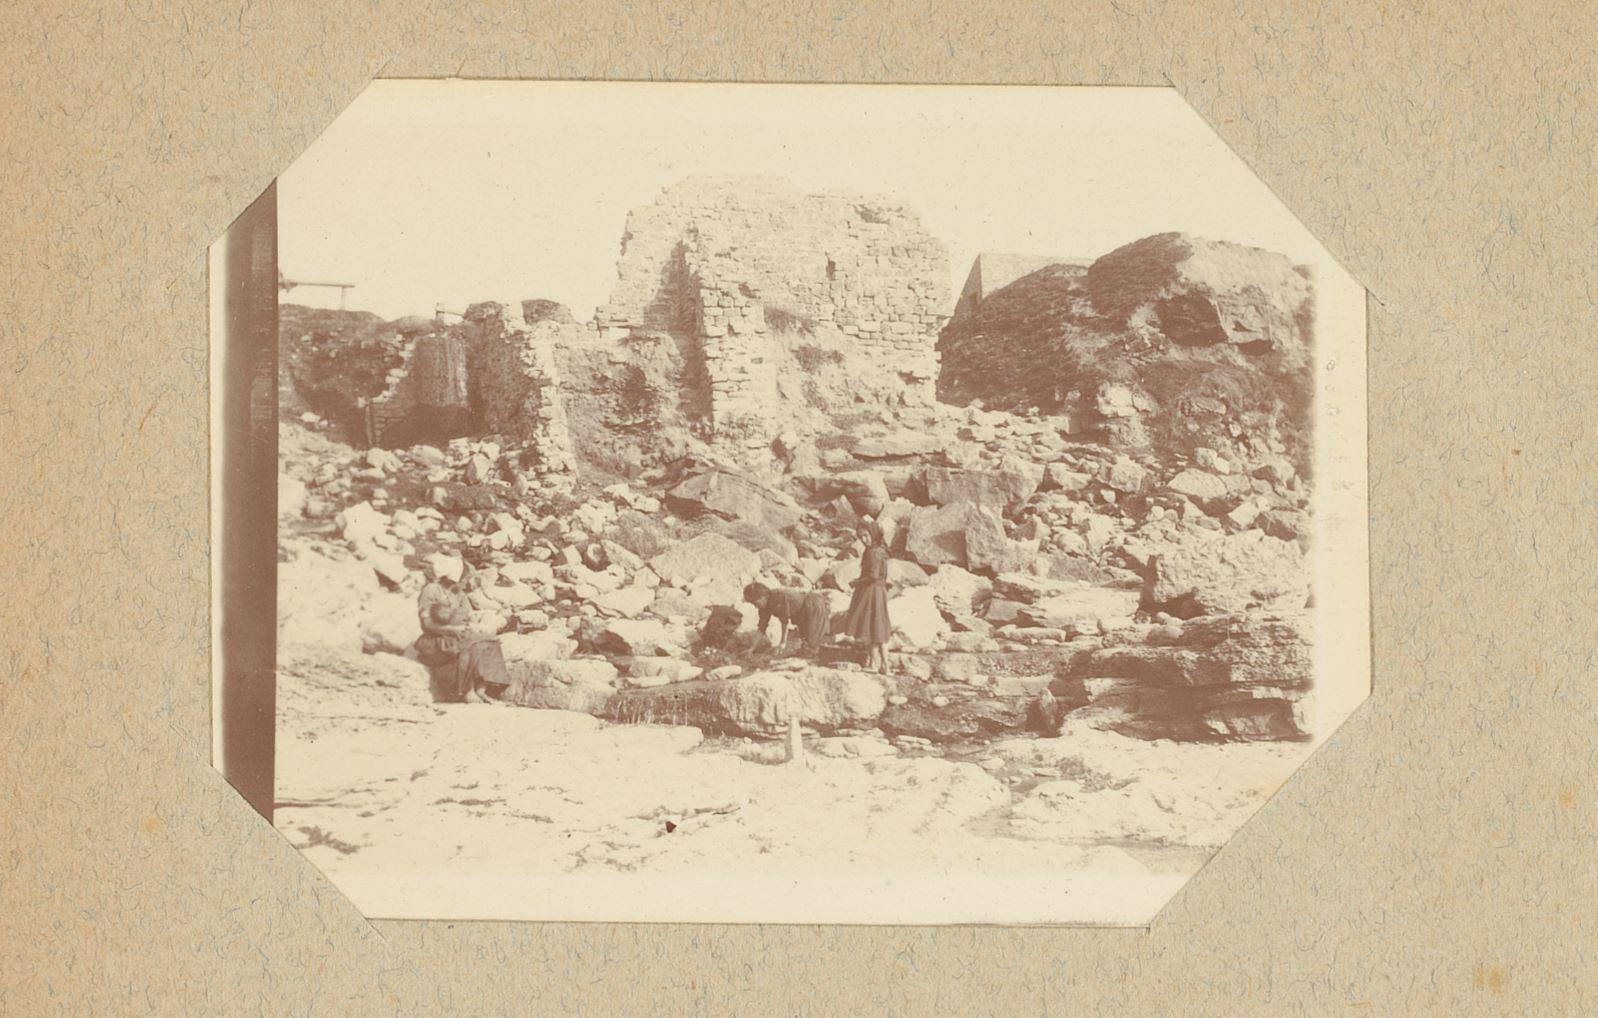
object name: album leaf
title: Vrouwen met wasgoed tussen rotsen bij een ruïne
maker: Anonymous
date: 1897-1900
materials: paper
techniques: gelatin silver print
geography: france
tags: rocky coast, laundering, france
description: Over de foto is een ander negatief afgedrukt van een voorstelling van bomen.